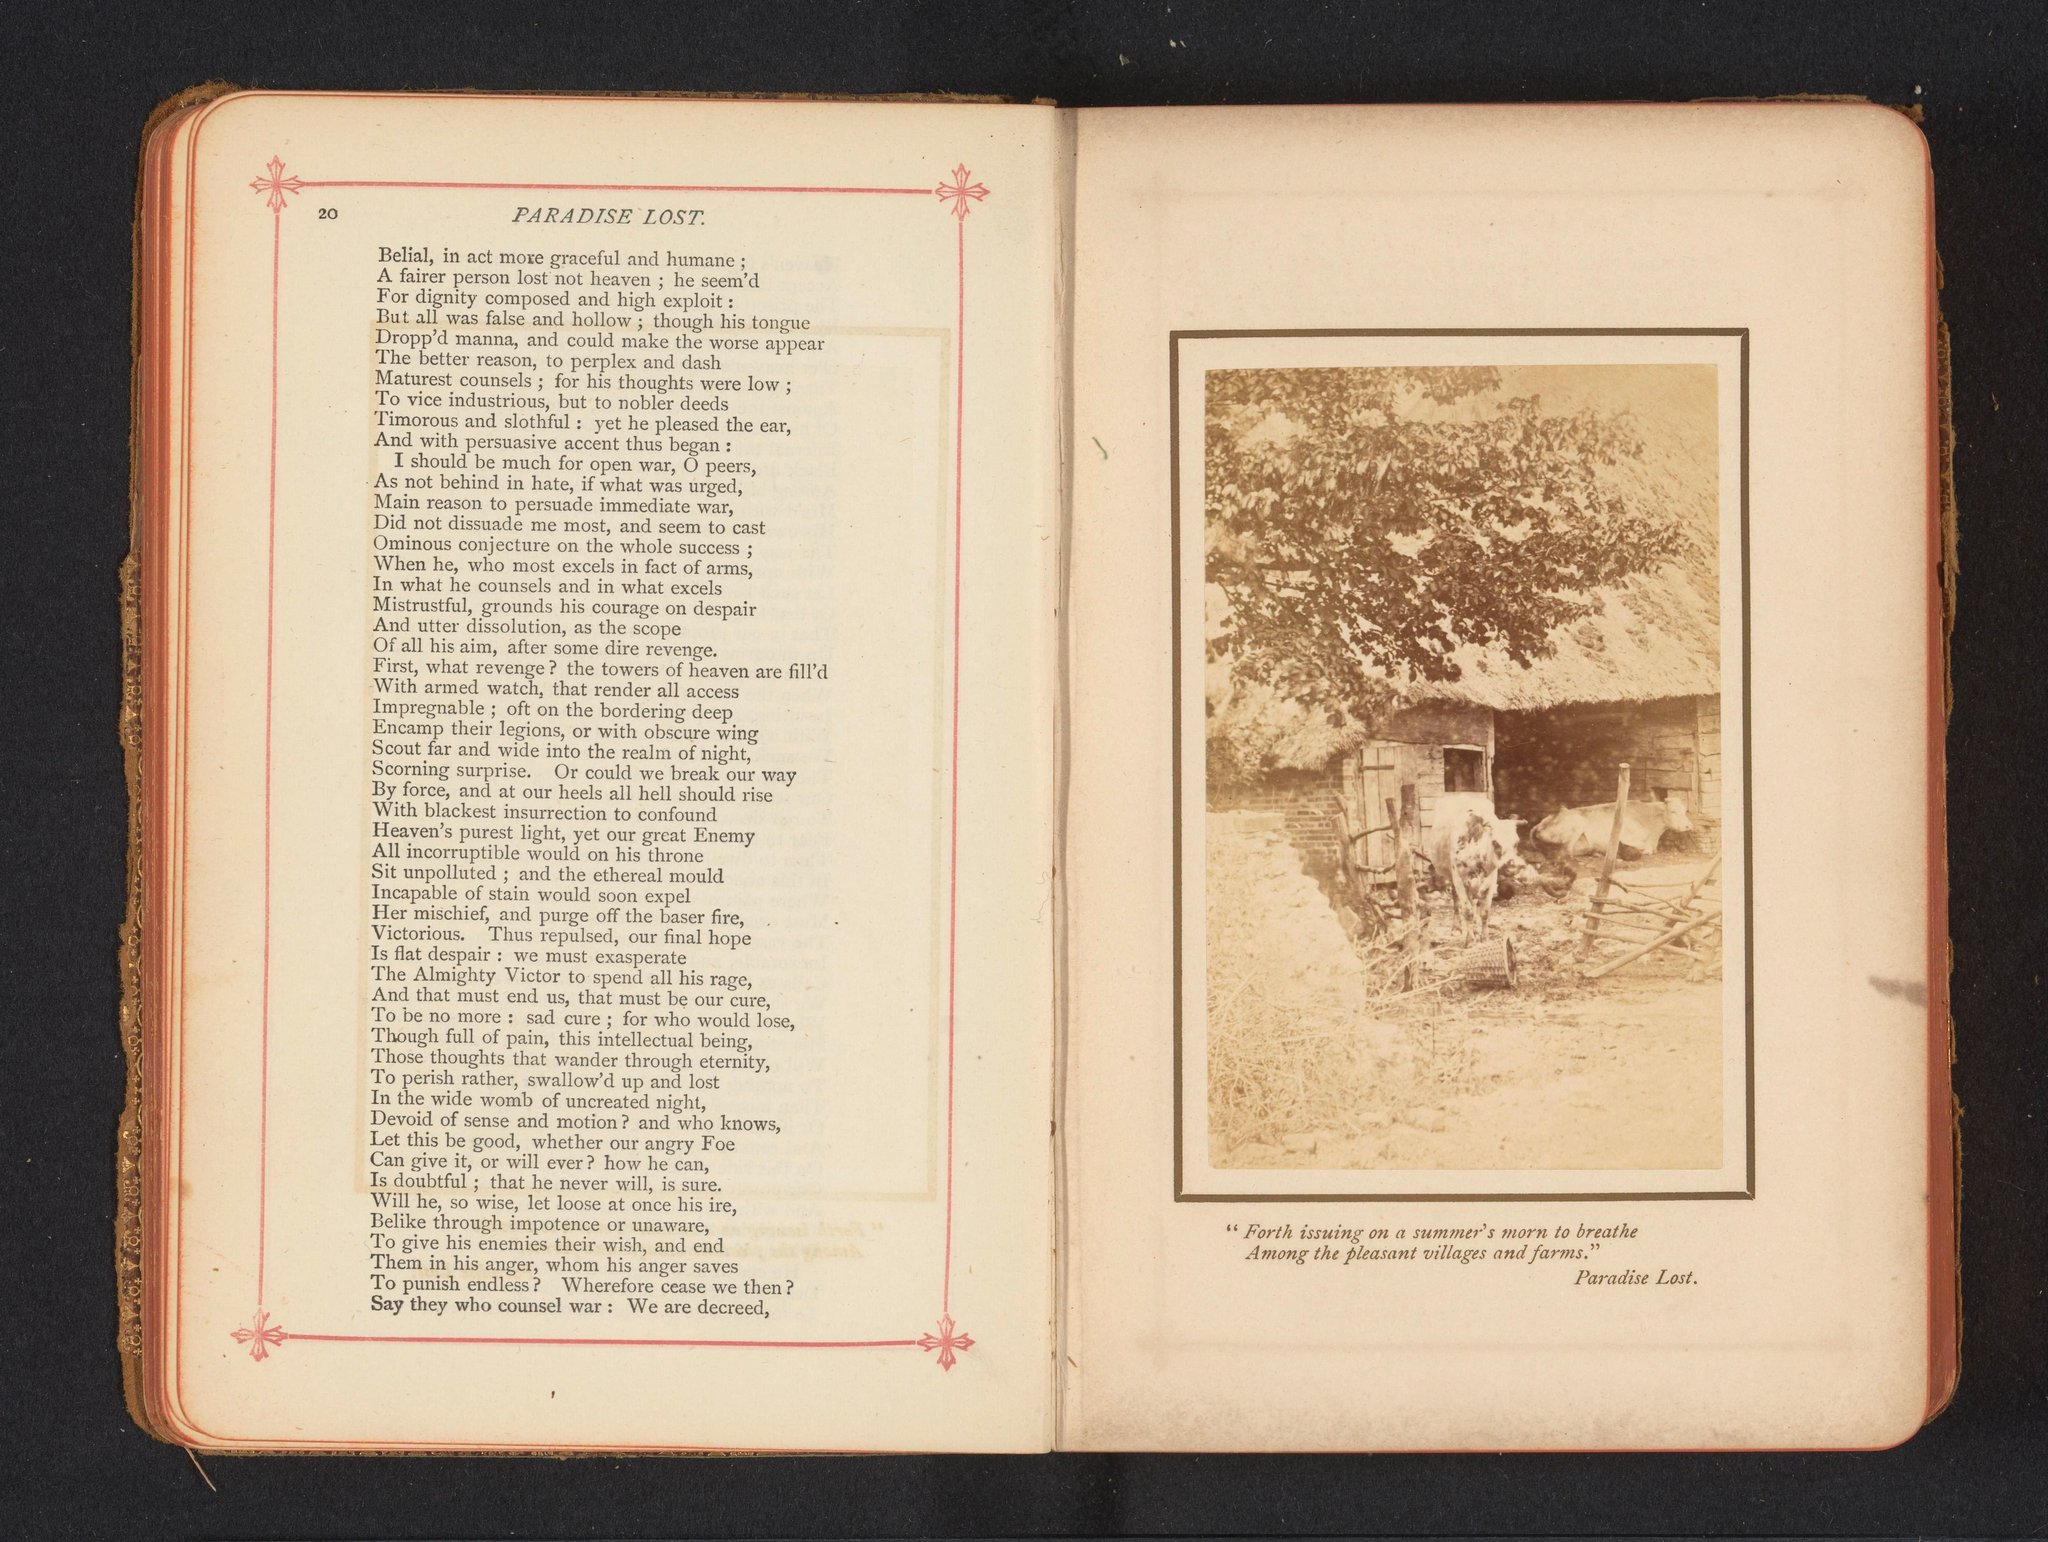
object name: page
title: Koeien in een stal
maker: deswall vaughan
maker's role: fotograaf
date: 1875-1885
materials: photographic support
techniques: albumen print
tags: cow, stall, stable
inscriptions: inscription: ‘" Forth issuing (...) and farms." Paradise Lost.’